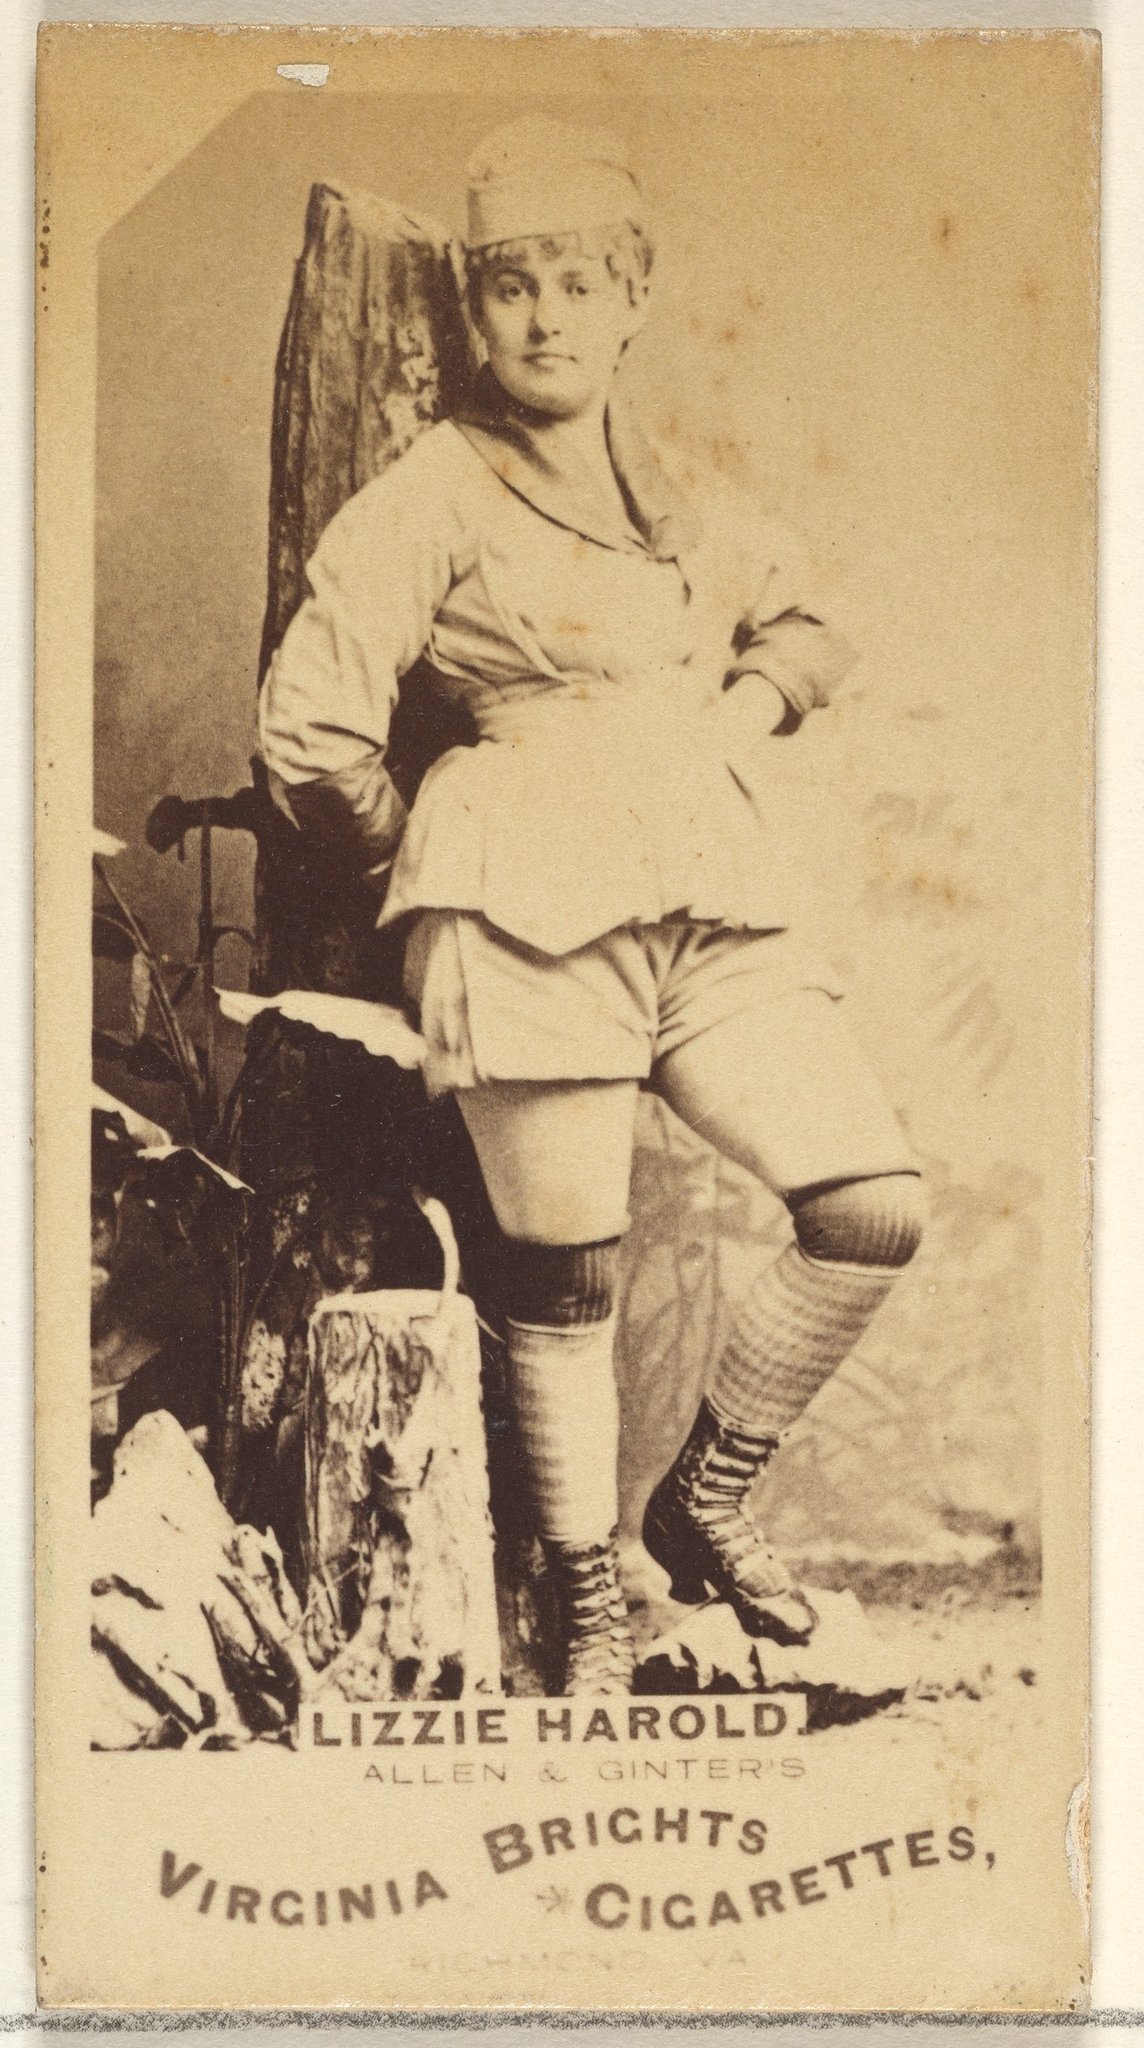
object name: photograph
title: Lizzie Harold, from the Actors and Actresses series (N45, Type 1) for Virginia Brights Cigarettes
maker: allen & ginter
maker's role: publisher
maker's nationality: american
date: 1888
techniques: albumen silver print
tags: portraits,women,actresses